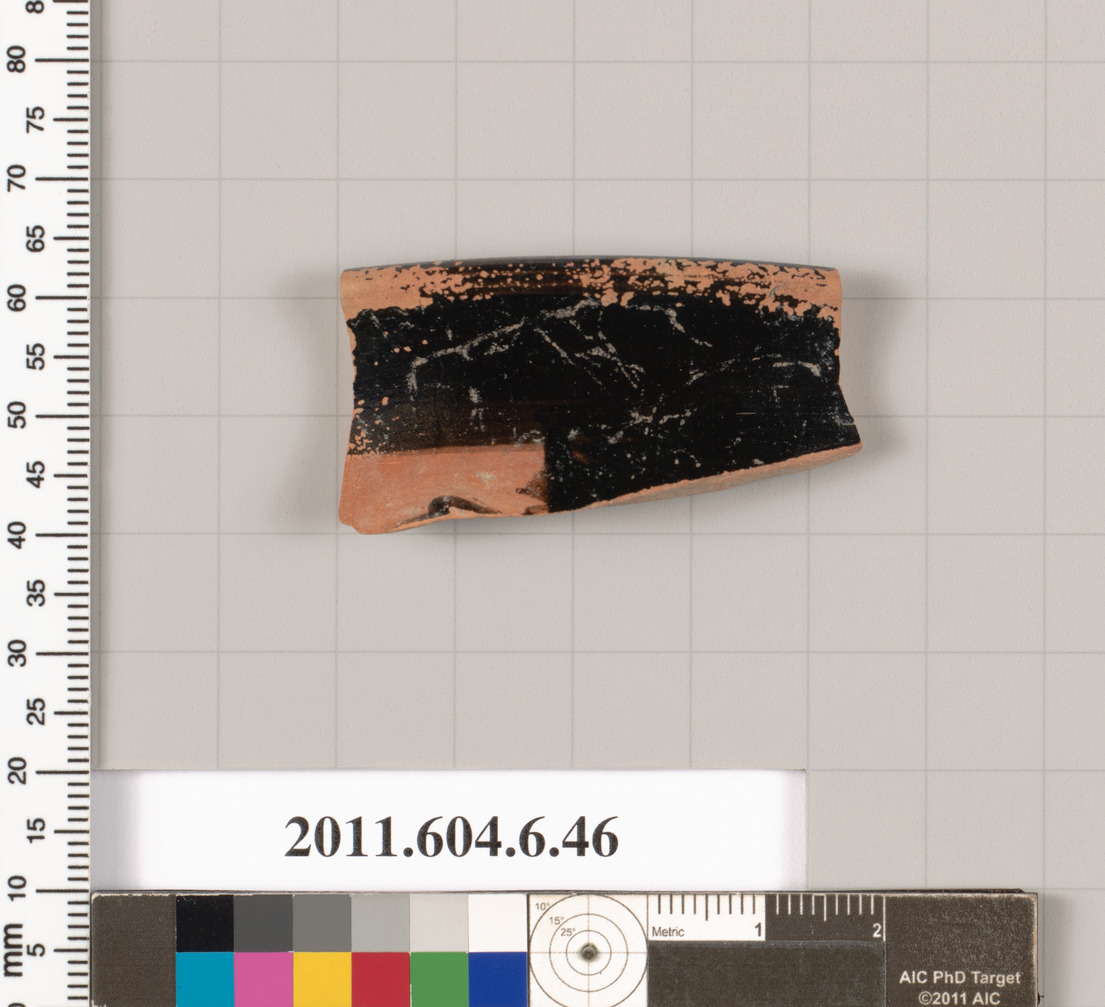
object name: olpe fragment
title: Terracotta fragment of olpe (jug)?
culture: greek, attic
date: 600-401 BCE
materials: terracotta